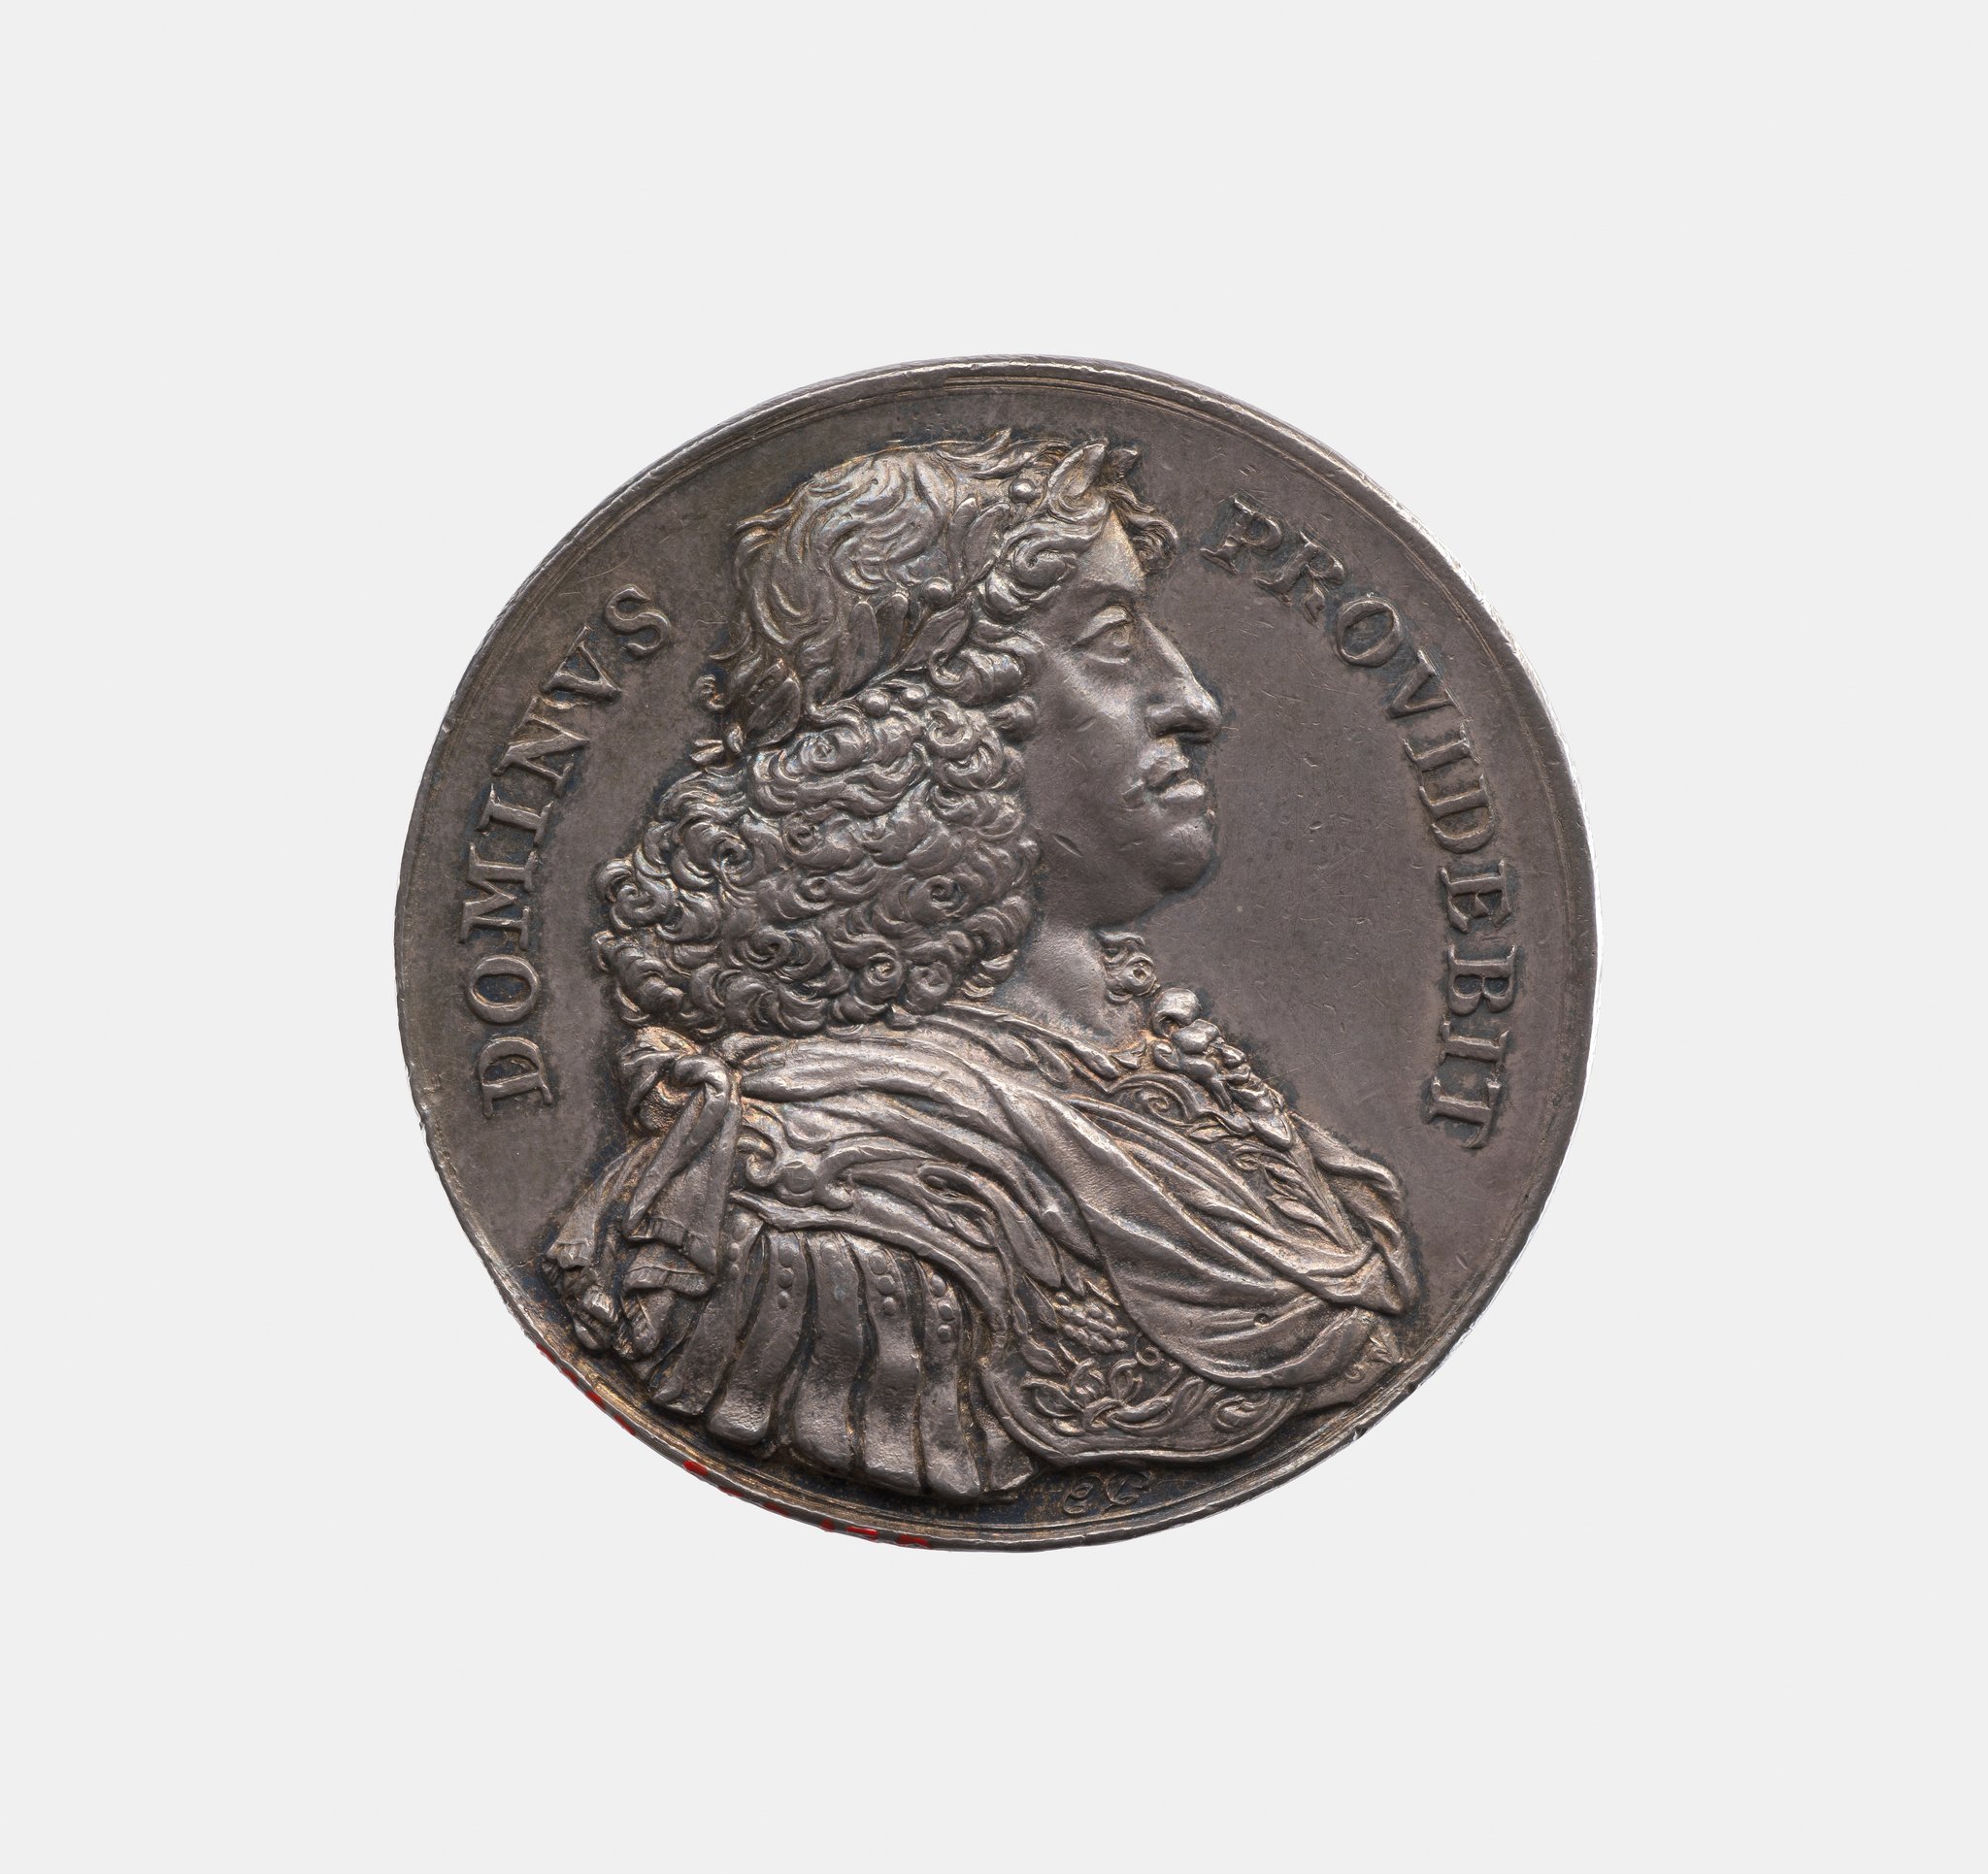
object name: medal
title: Frederick III 1609-70, King of Denmark 1648-70 and his wife Sophia Amalia of Brunswick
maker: erich parise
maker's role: artist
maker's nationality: danish, copenhagen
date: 1658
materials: silver